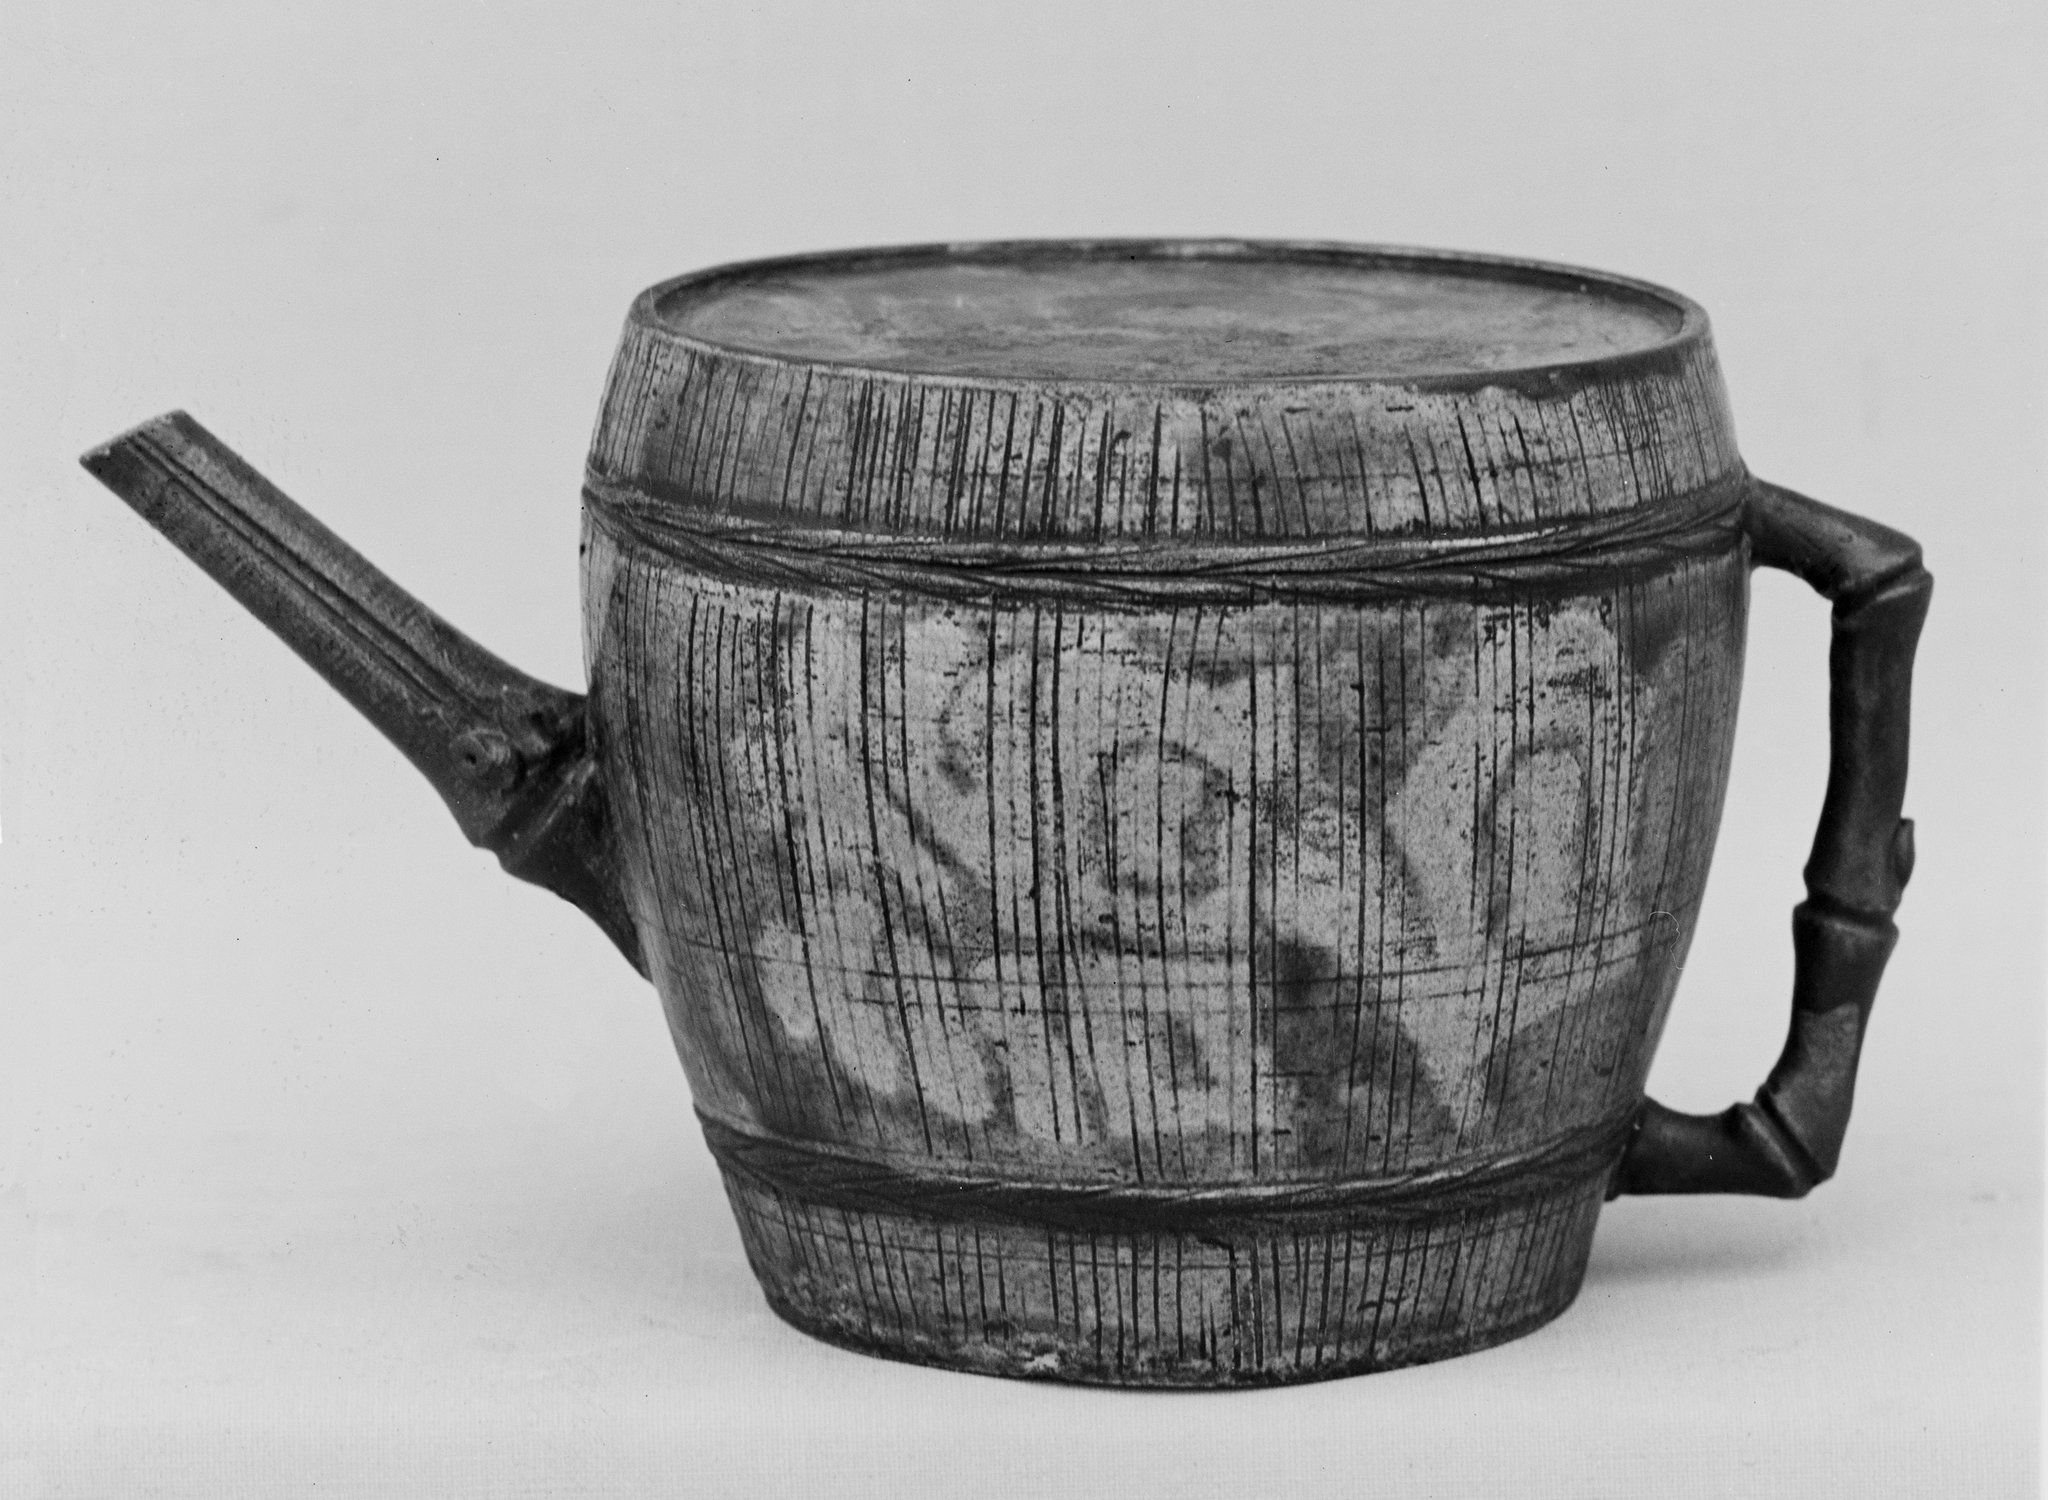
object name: water pot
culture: japanese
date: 1801-1900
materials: glaze, pottery